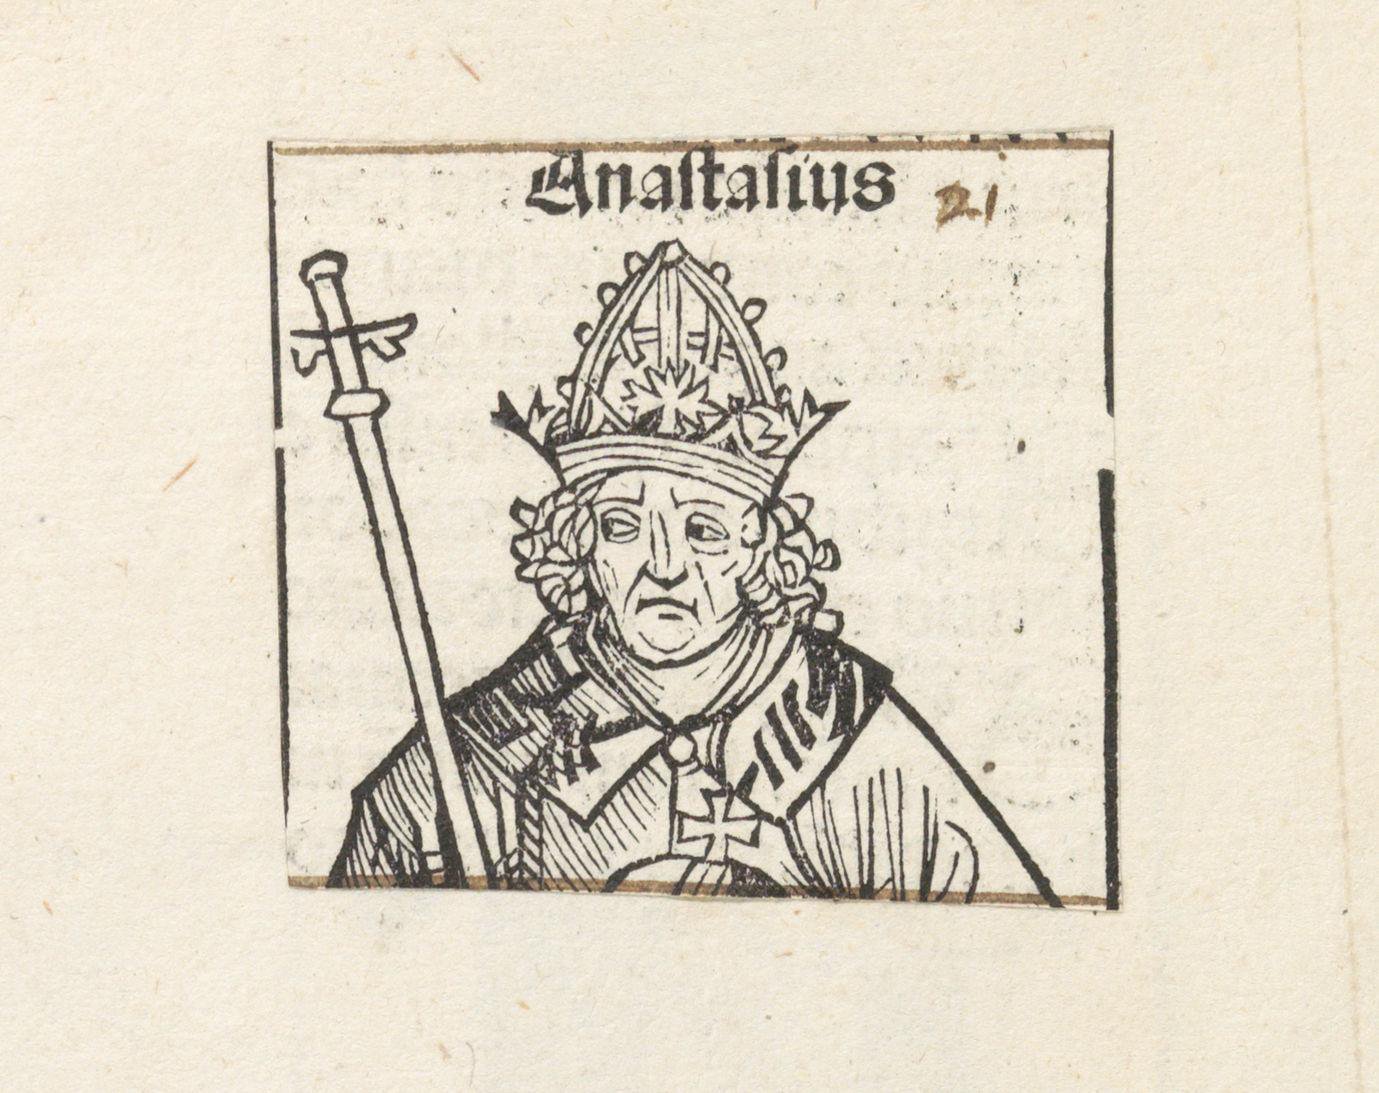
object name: print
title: Anastasius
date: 1493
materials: paper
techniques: letterpress printing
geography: nuremberg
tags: emperor, king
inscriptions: inscription: ‘21’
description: Een halve koning, naar voren gericht. De man heeft een scepter en een rijksappel in zijn handen. De voorstelling is onderdeel van de opeenvolging Romeinse keizers in de Liber Chronicarum. De tekst identificeert de man als keizer Anastasius I. De prent maakt deel uit van een album.